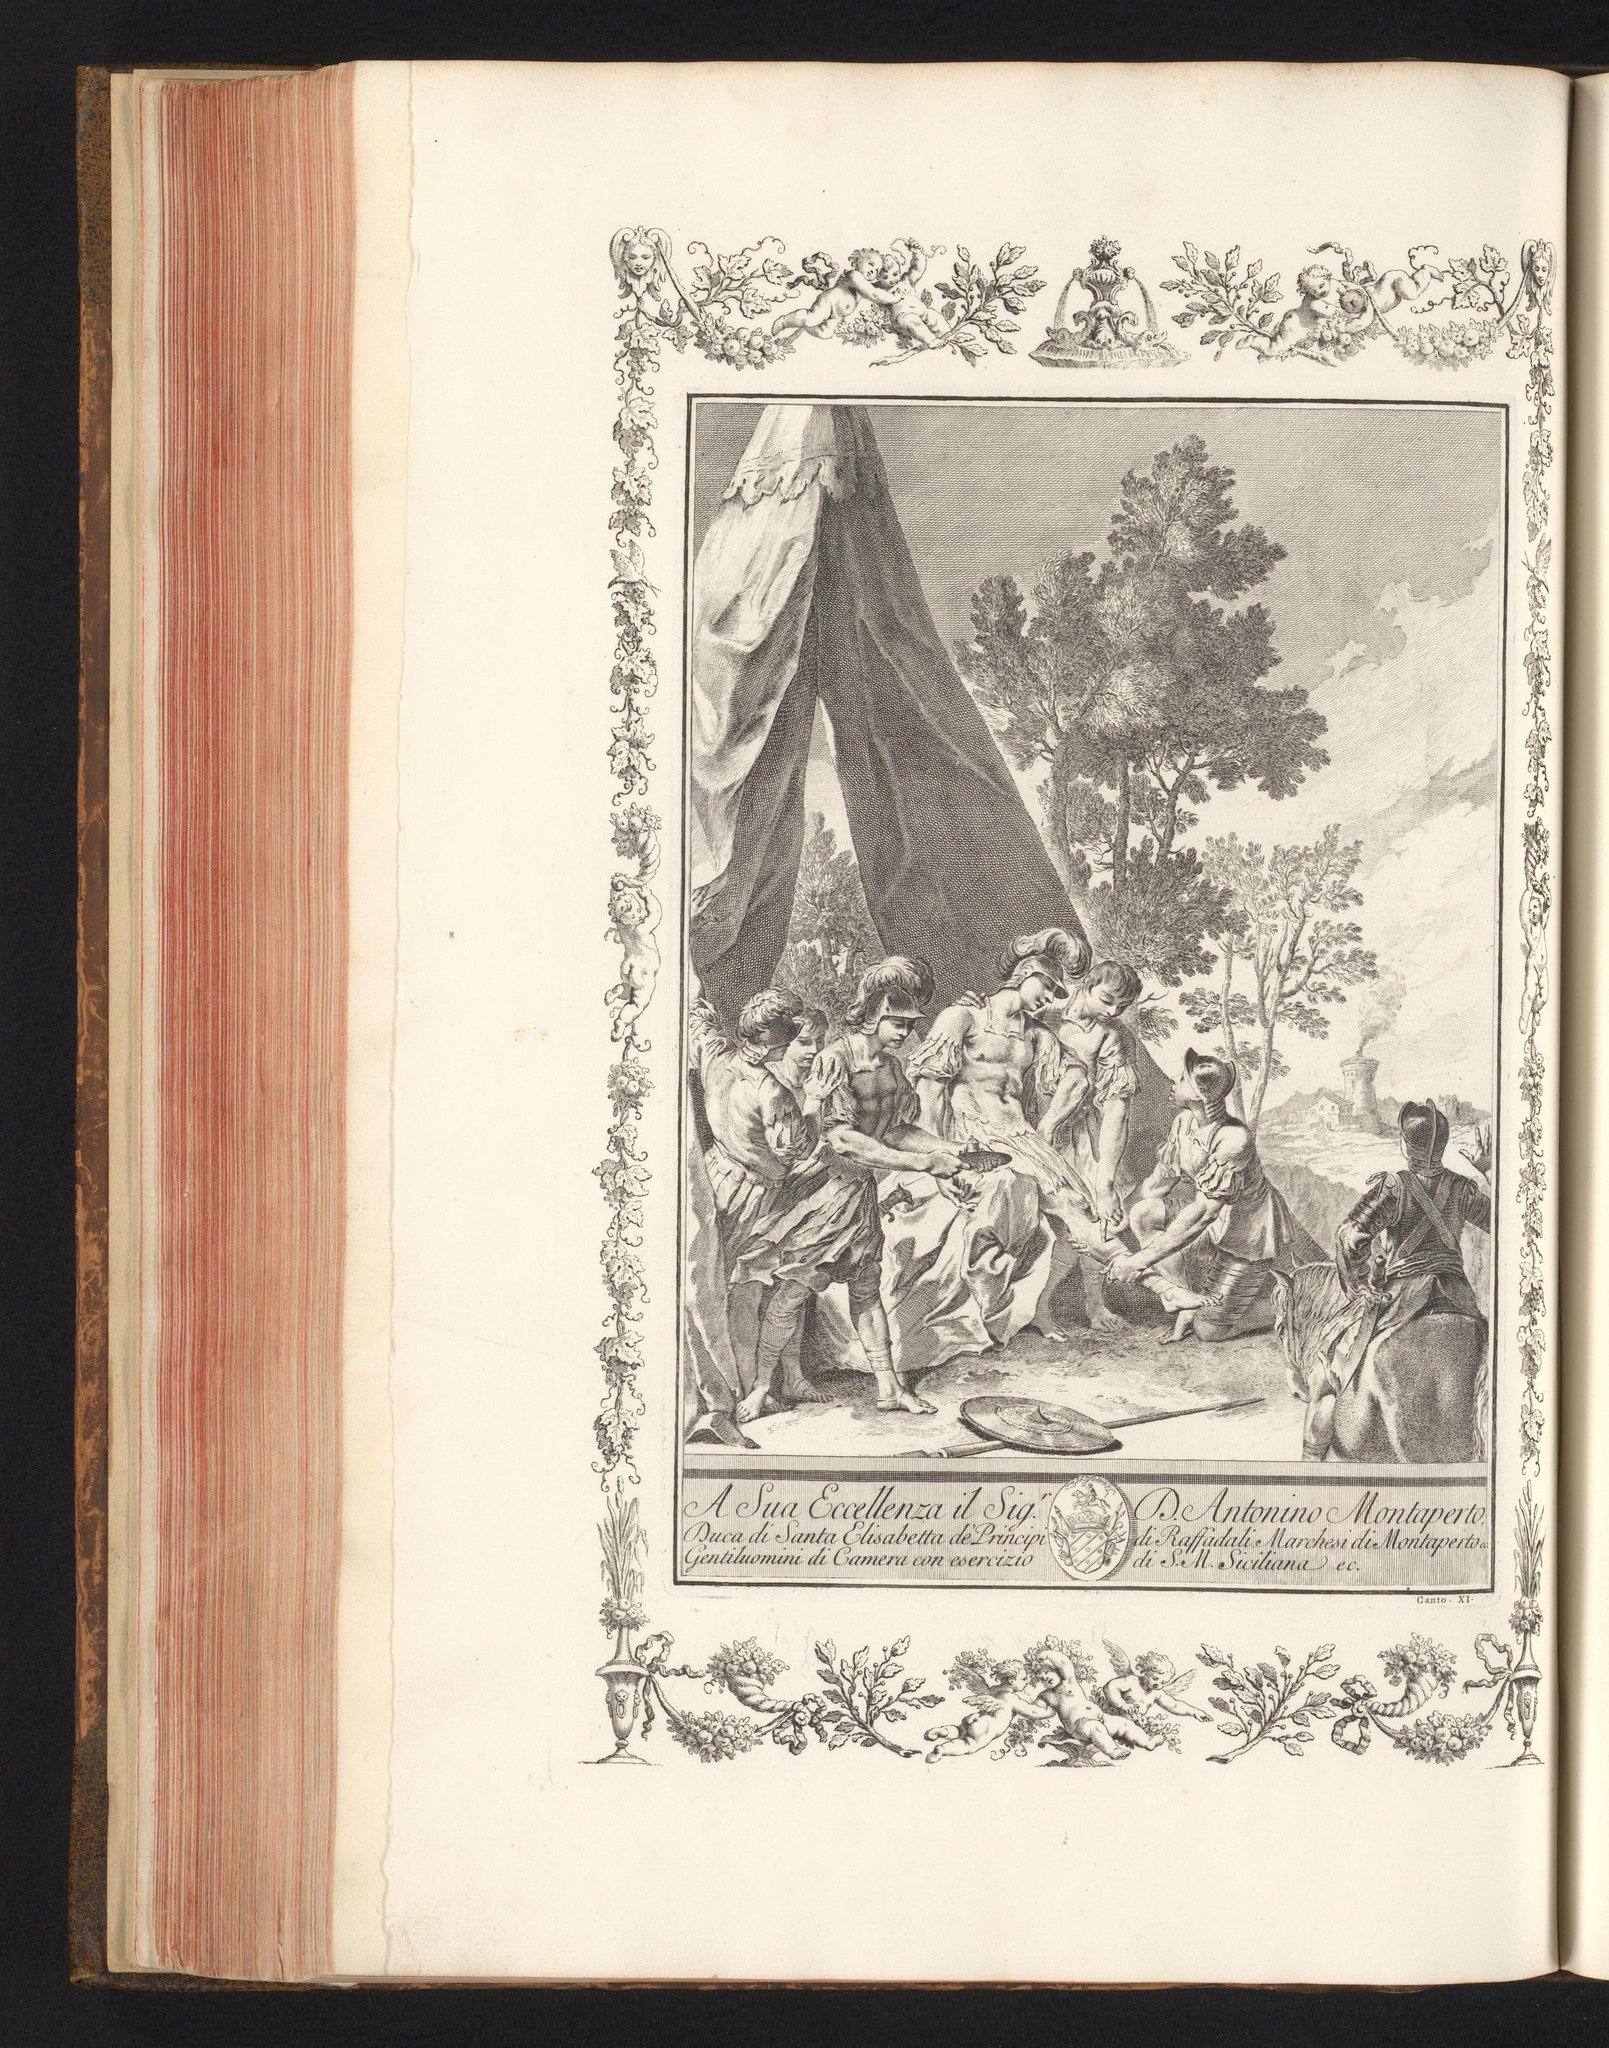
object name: page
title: Soldaten verbinden de wond aan het been van een van hen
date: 1745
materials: paper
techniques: etching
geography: venice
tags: (military) camp with tents, infections and wounds, (scenes from) specific works of literature: tasso, gerusalemme liberata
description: Prent uit: Tasso, Torquato. La Gerusalemme liberata di Torquato Tasso con le figure de Giambatista Piazzetta. Venetië: Giambatista Albrizzi, 1745.